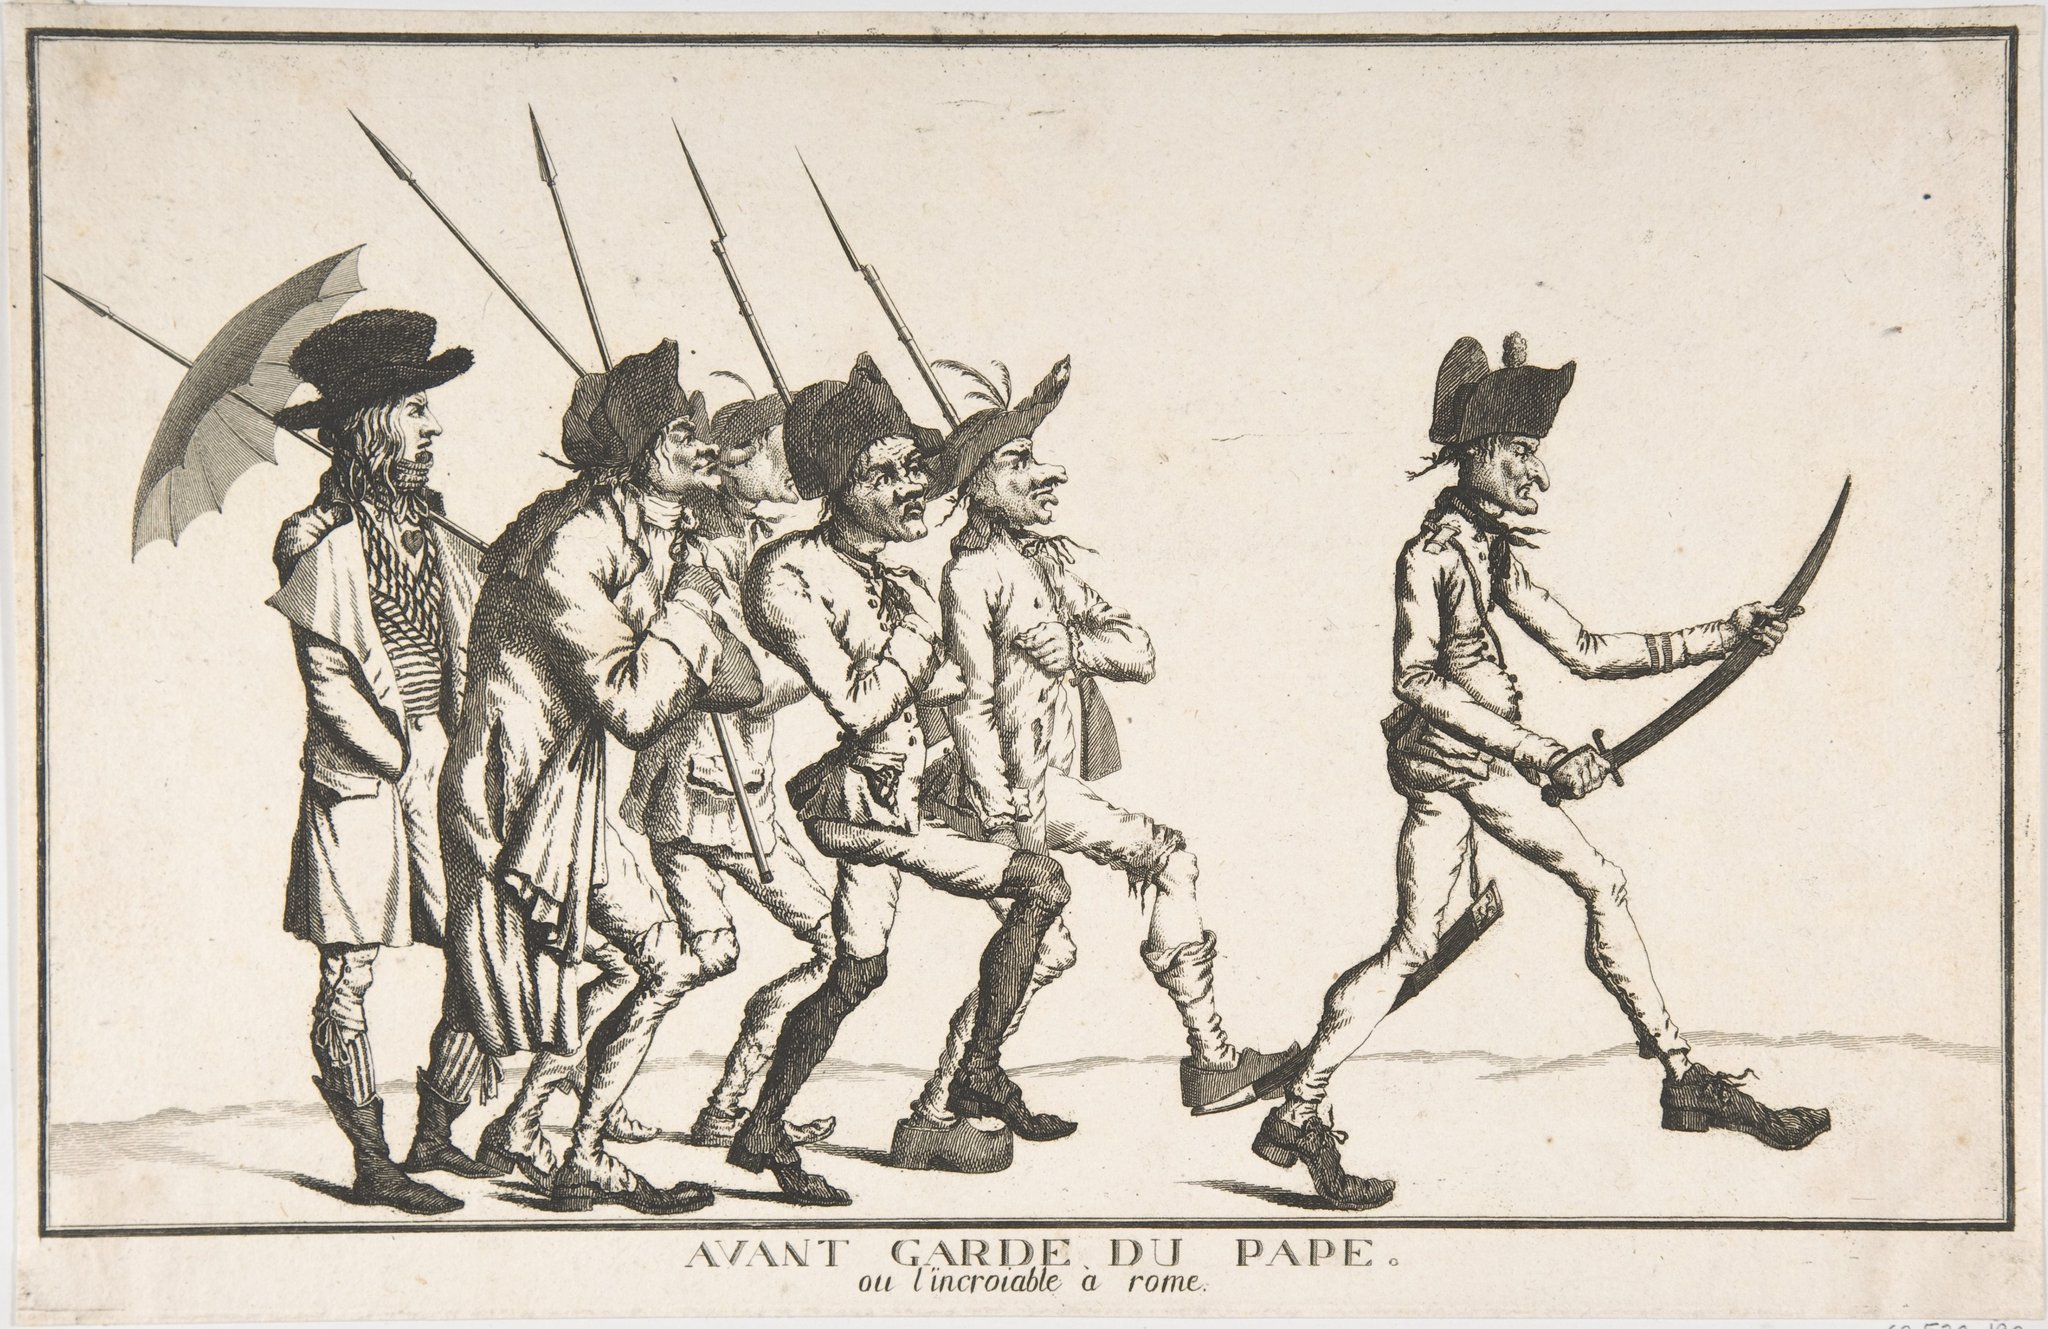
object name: print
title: The Pope's Advance Guard or the "Incroyable" in Rome (Avant garde du pape, ou l'Incroyable à Rome)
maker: anonymous, french, 18th century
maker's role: artist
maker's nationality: french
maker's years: 1700-1800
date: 1767-1800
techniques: etching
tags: satire,soldiers,men